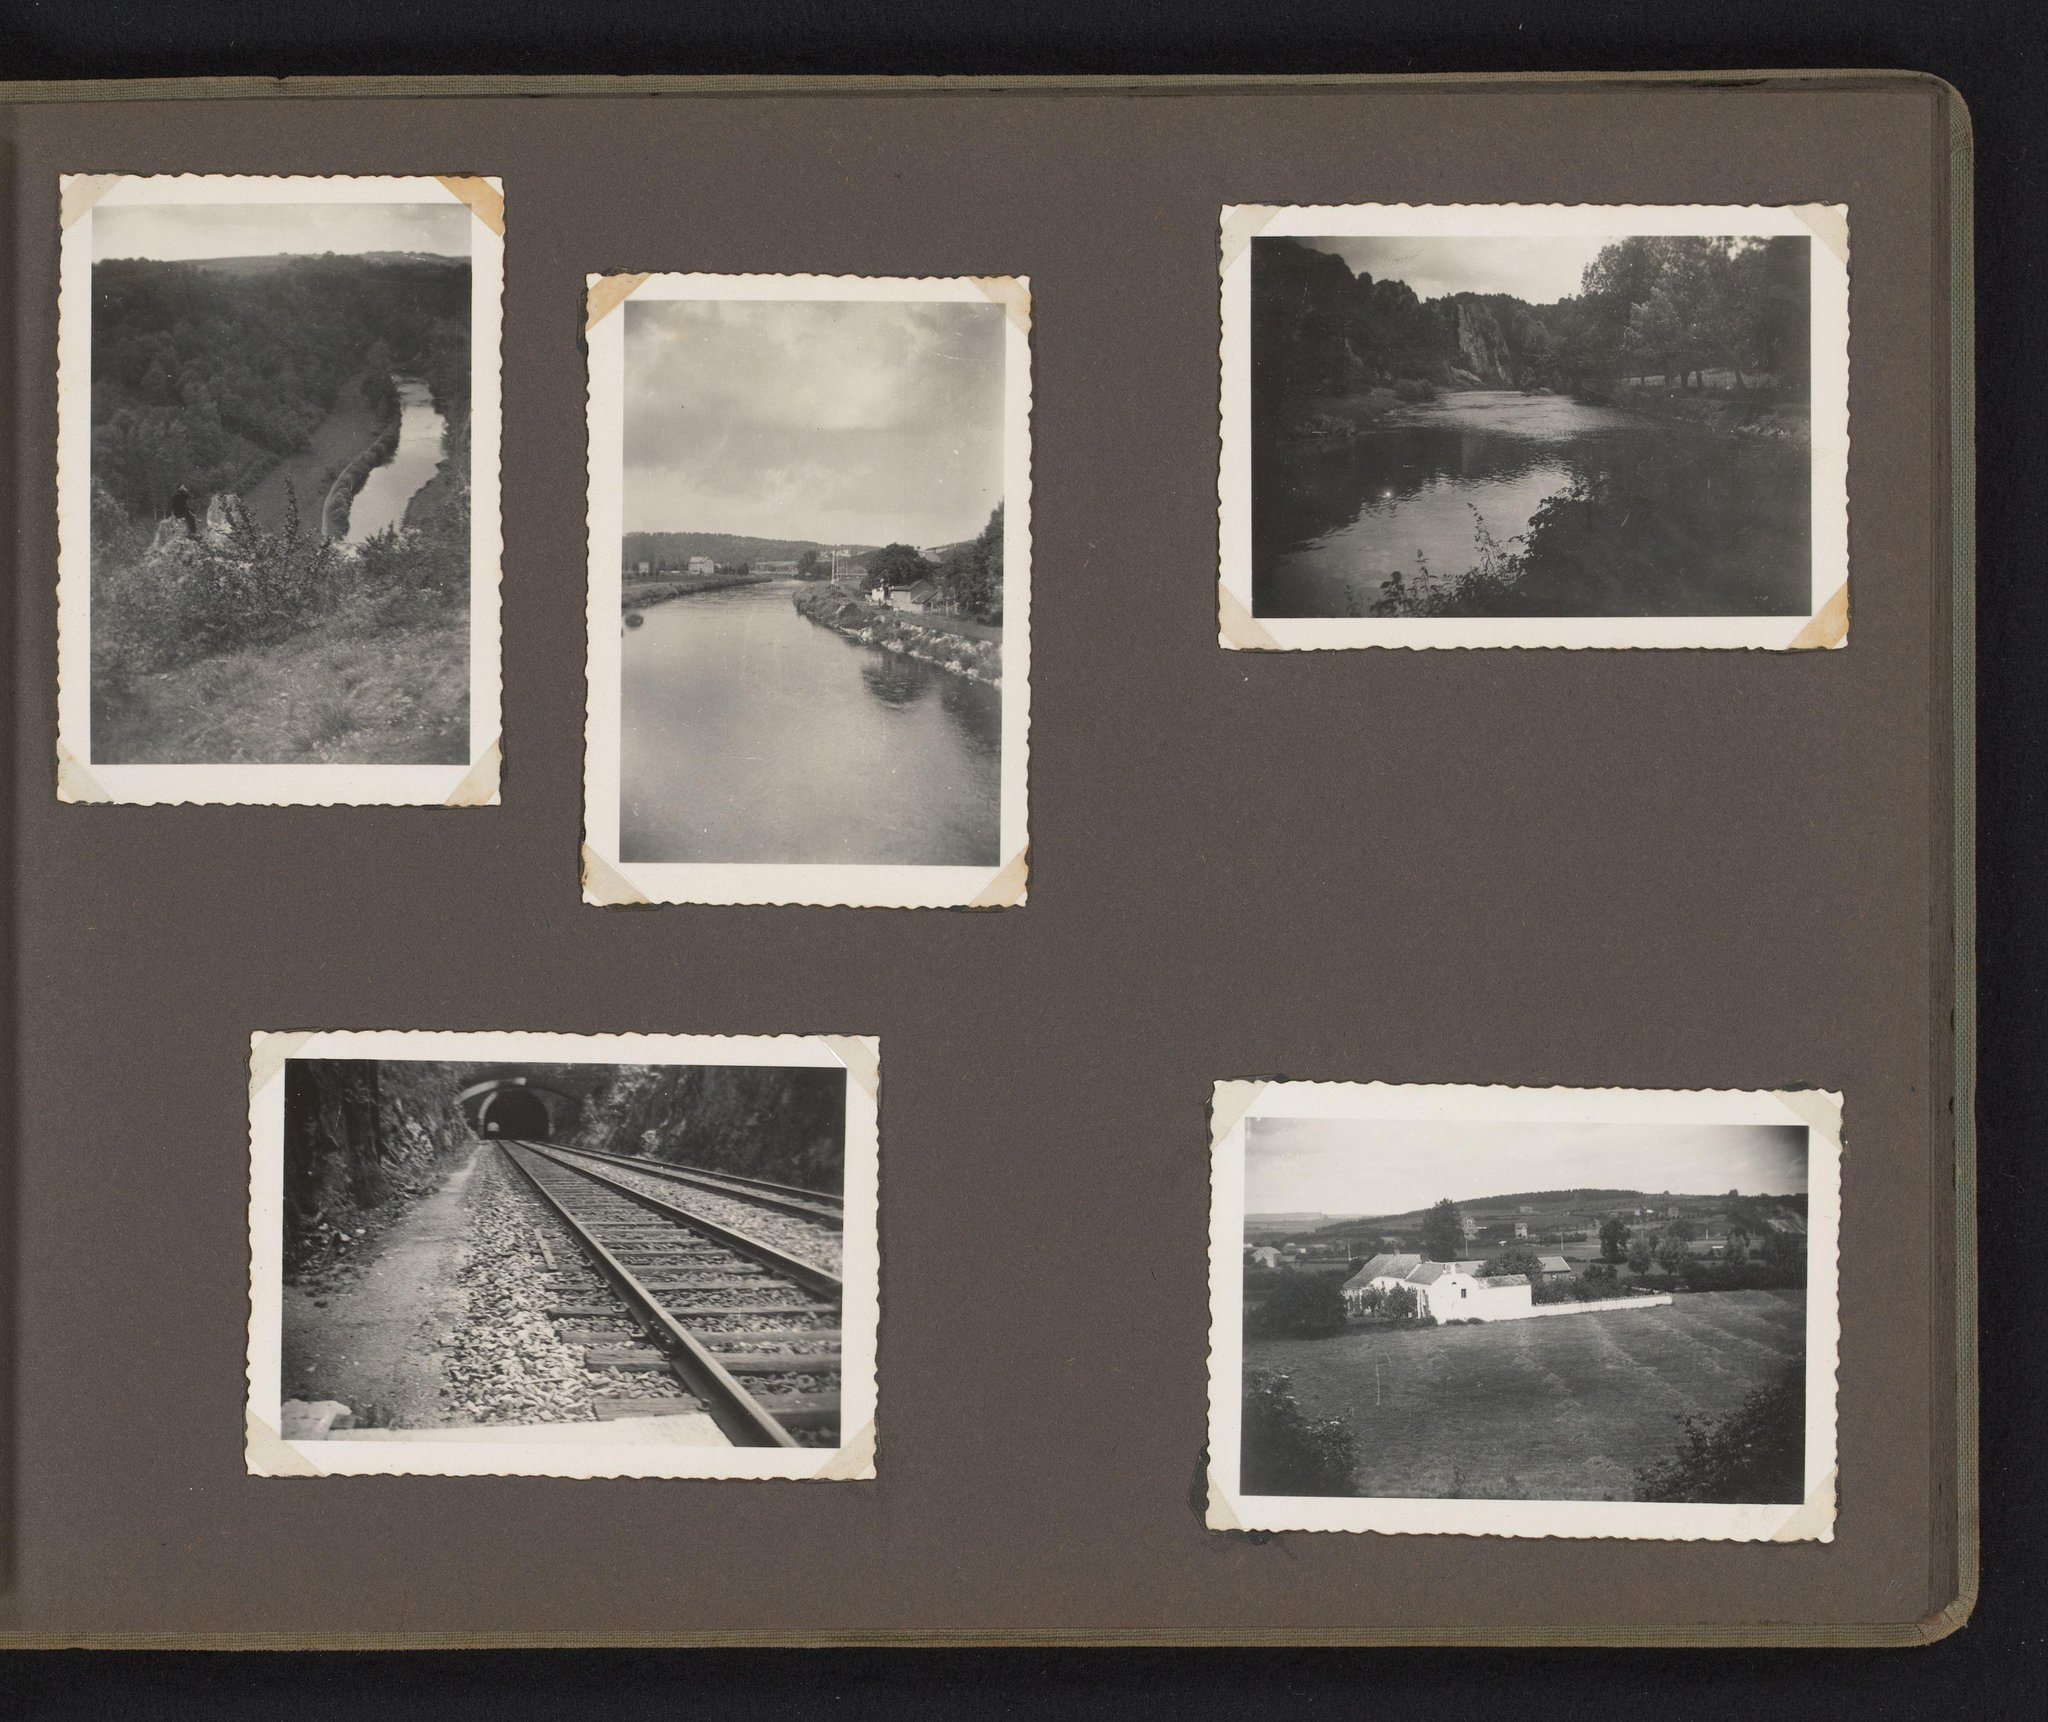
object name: album leaf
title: Landschappen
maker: Anonymous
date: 1935-1945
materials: cardboard, photographic support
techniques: gelatin silver print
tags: outing, pleasure trip, open-air recreation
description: Albumblad met vijf foto's van landschappen tijdens een vakantie met een groep vrienden in het buitenland. Onderdeel van het fotoalbum van een jonge vrouw, ca. 1935-1945.